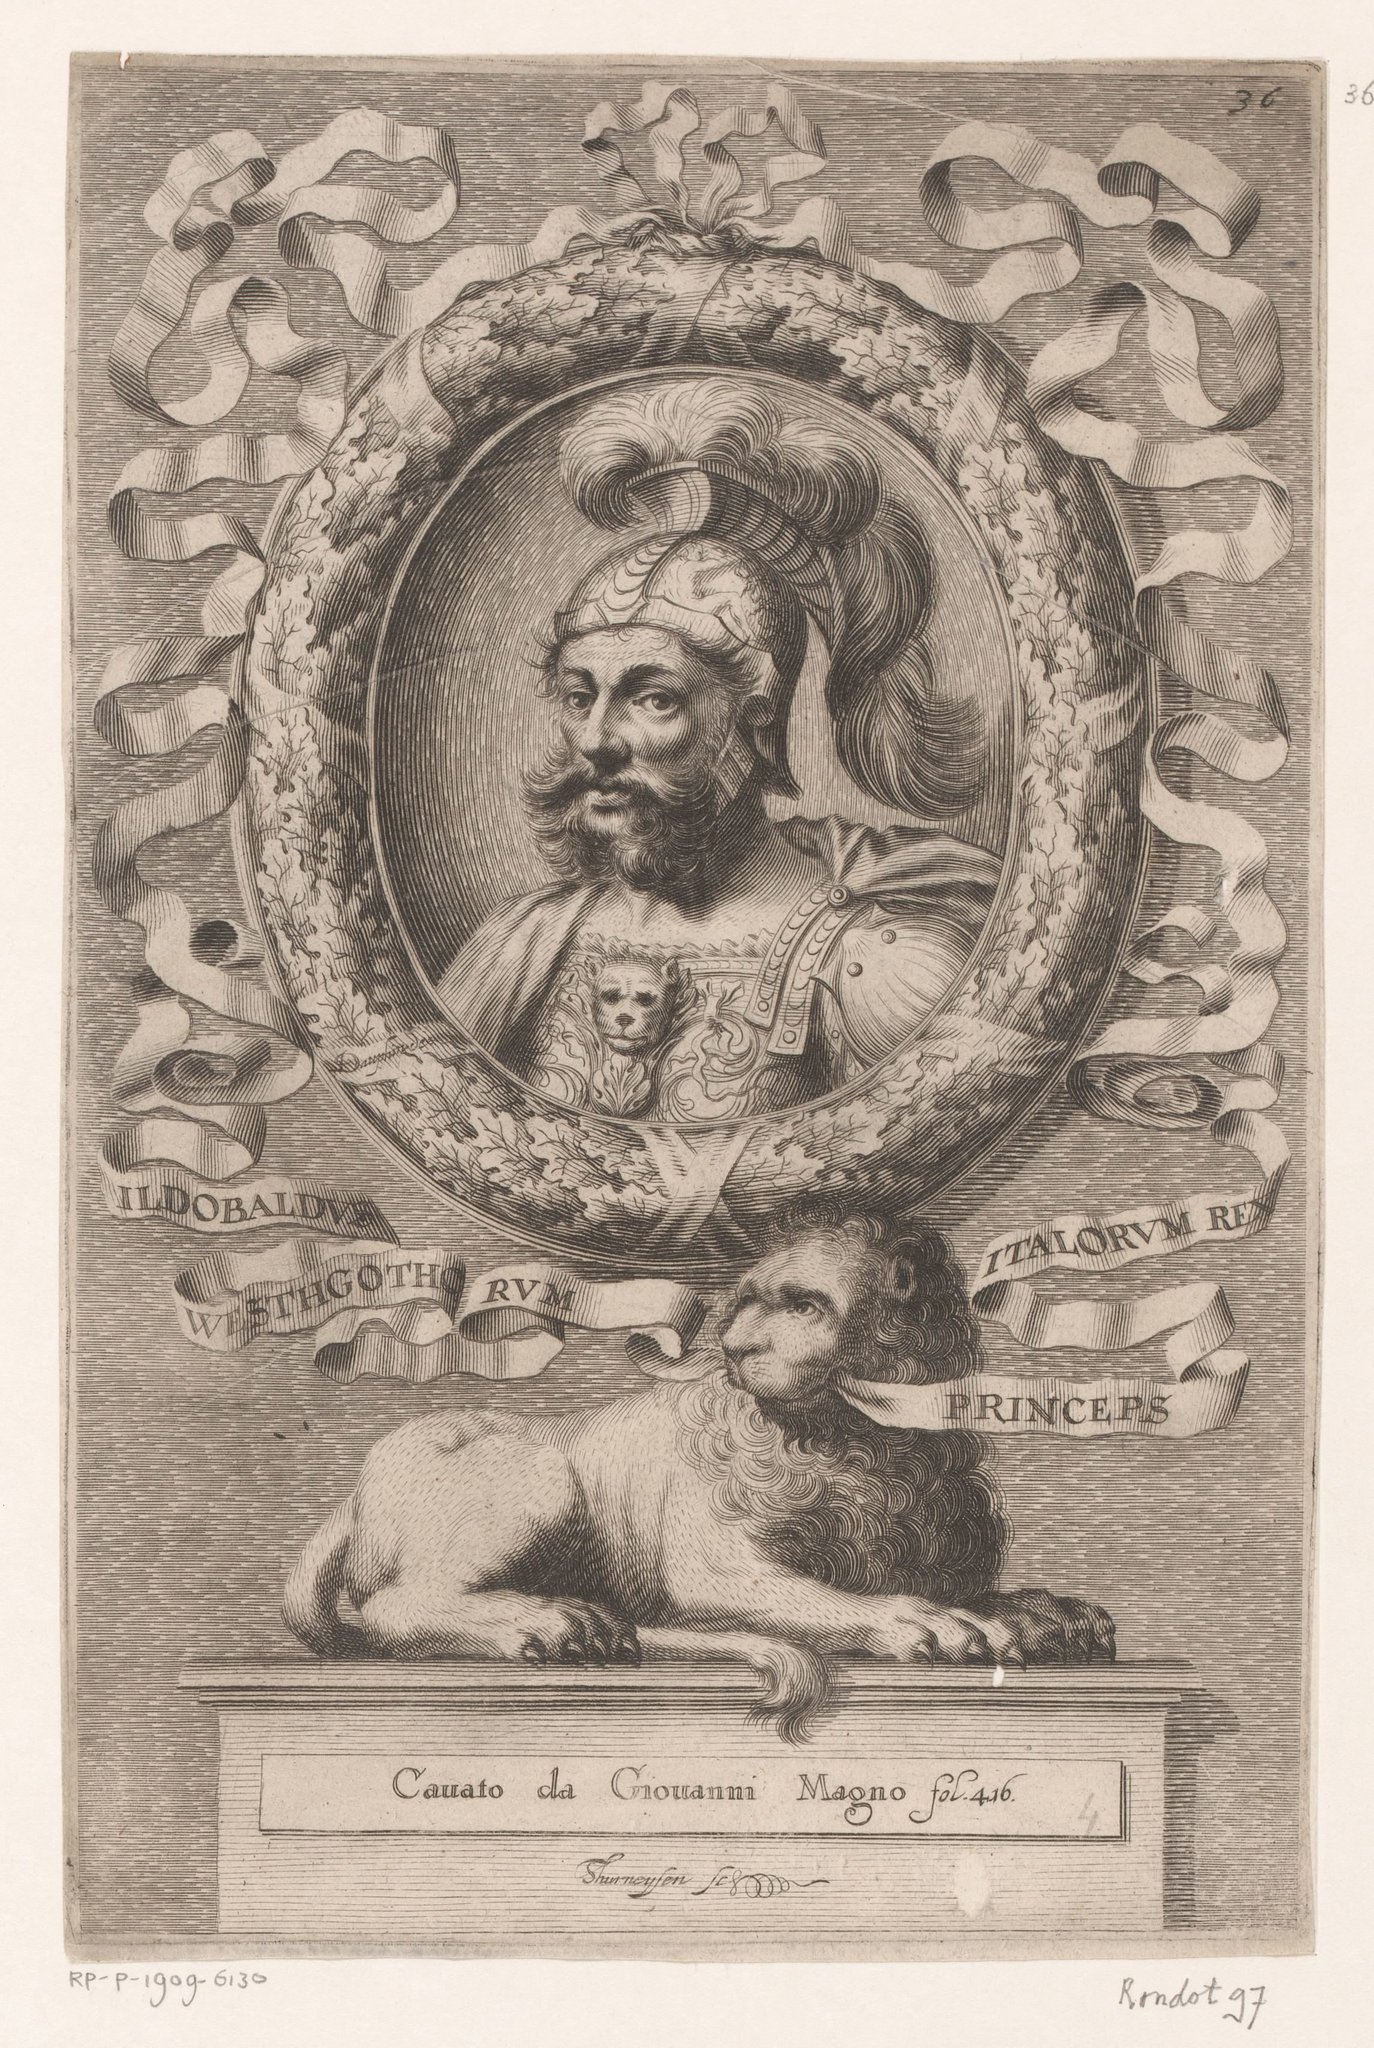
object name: print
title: Portret van Cosimo III de' Medici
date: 1661-1711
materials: paper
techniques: engraving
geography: basel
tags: cosimo iii de' medici, historical persons, armorial bearing, heraldry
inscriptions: collector's mark: Lugt 2228